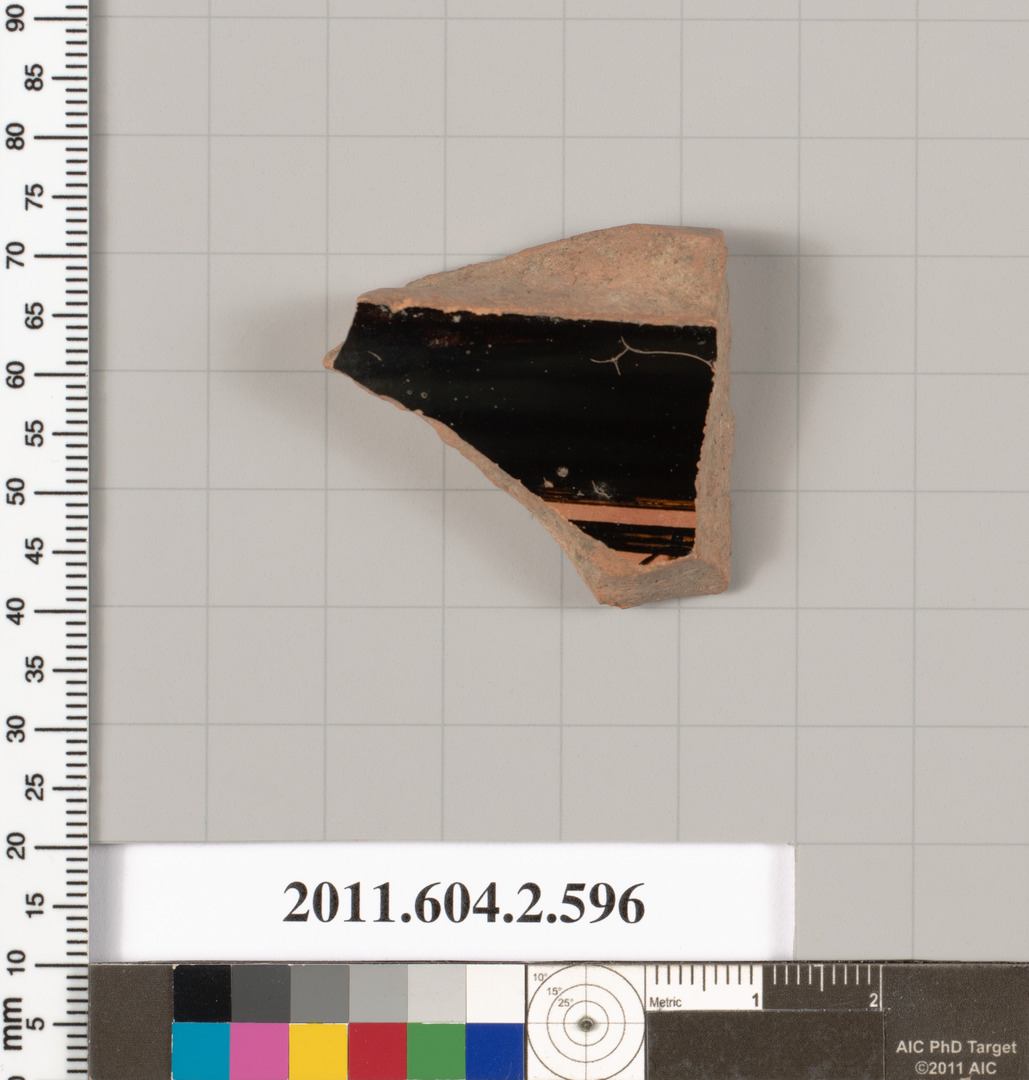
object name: column krater fragment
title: Terracotta fragment of a column-krater (bowl for mixing wine and water)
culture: greek, attic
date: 470-440 BCE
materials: terracotta